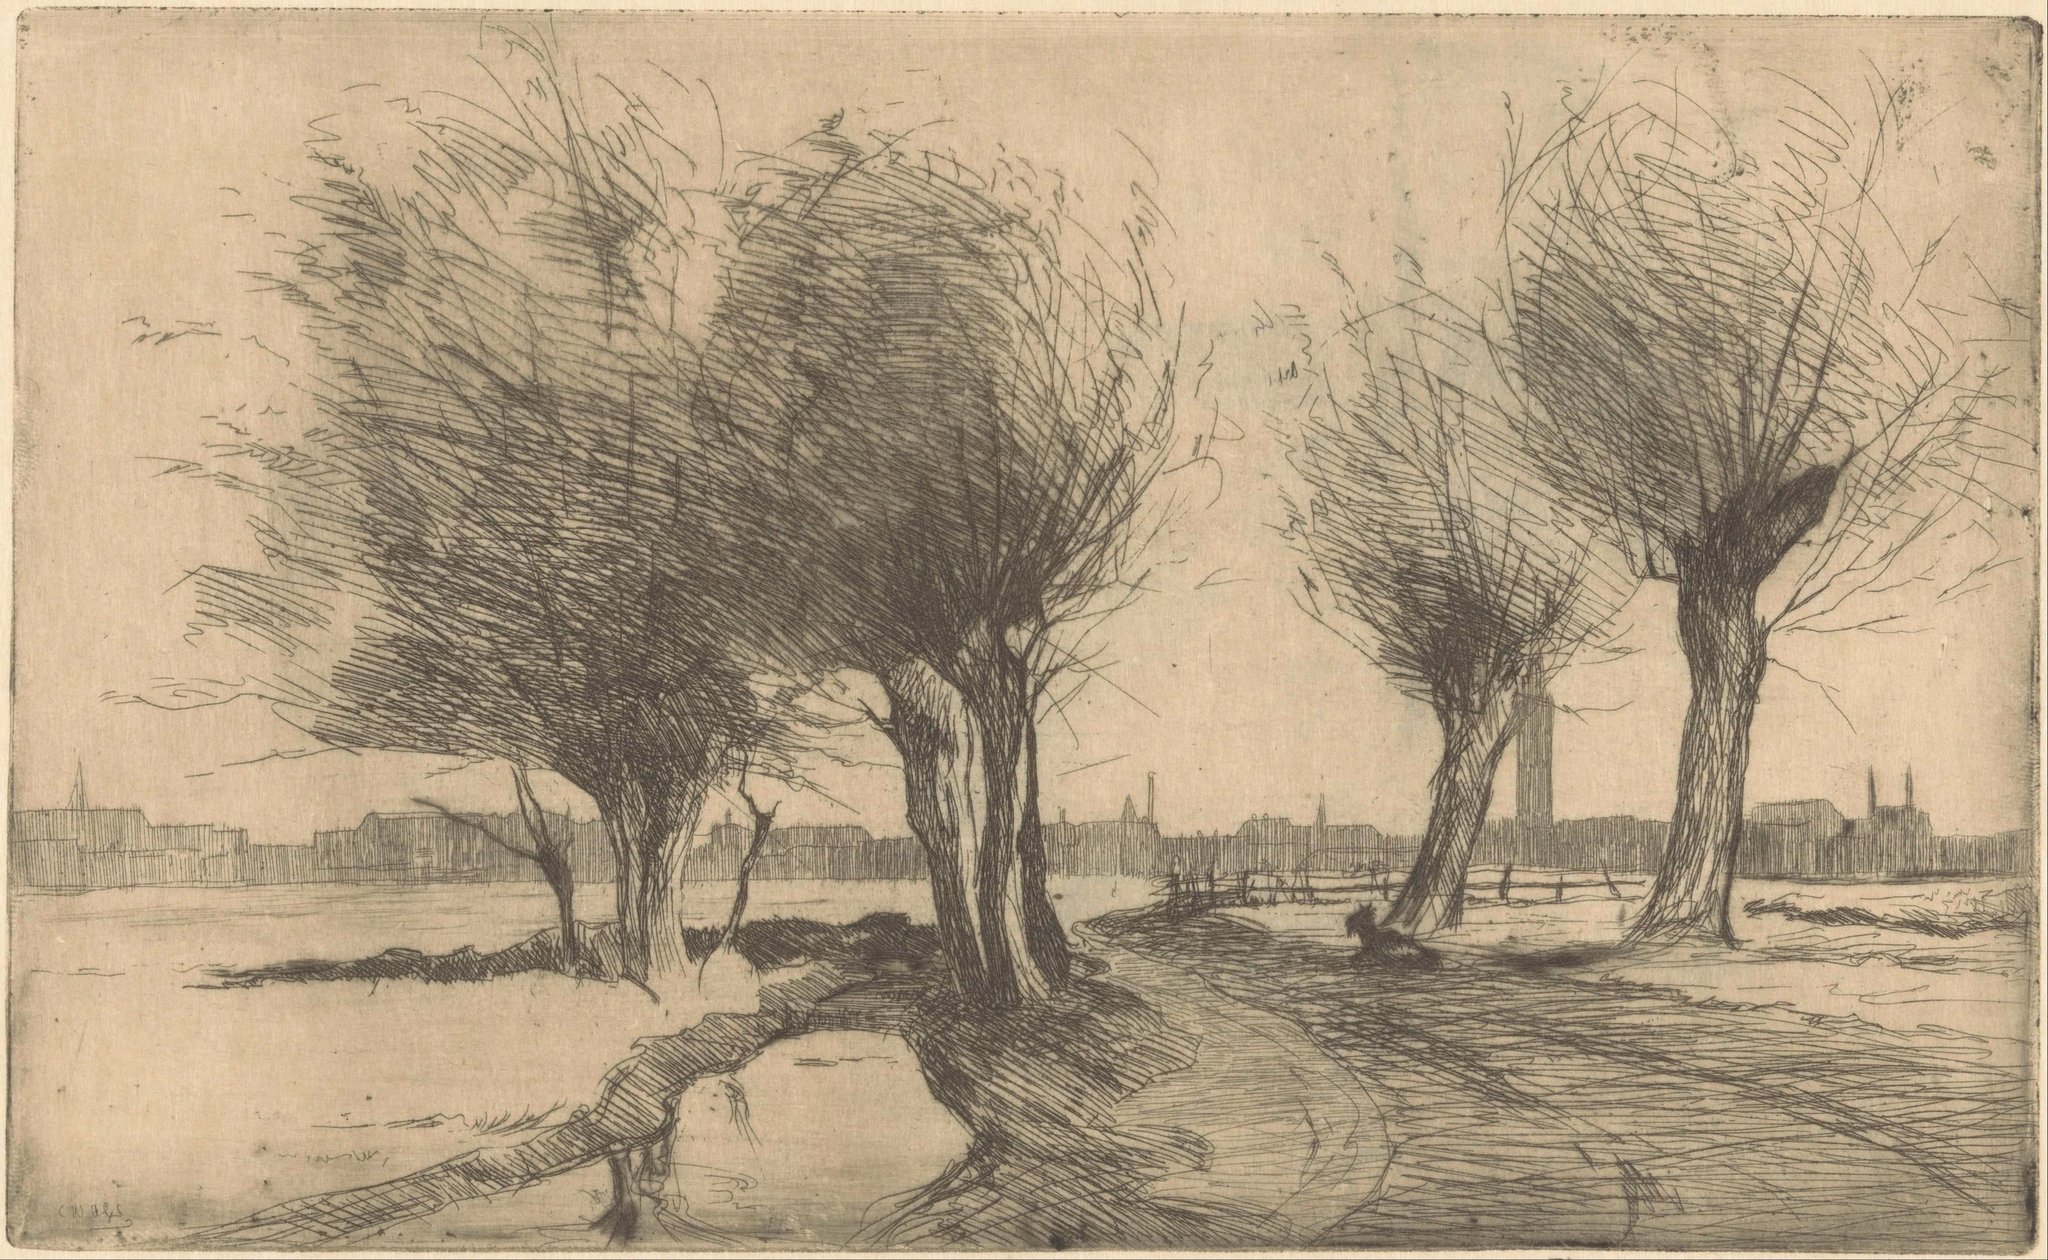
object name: print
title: Wilgen aan de sloot in de Binckhorst in Den Haag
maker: willem adrianus grondhout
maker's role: draughtsman, painter, print maker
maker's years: 1878-1934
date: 1888-1934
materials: paper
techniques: etching, intaglio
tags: trees: willow, small canal, ditch, prospect of city, town panorama, silhouette of city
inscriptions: collector's mark: Lugt 2228